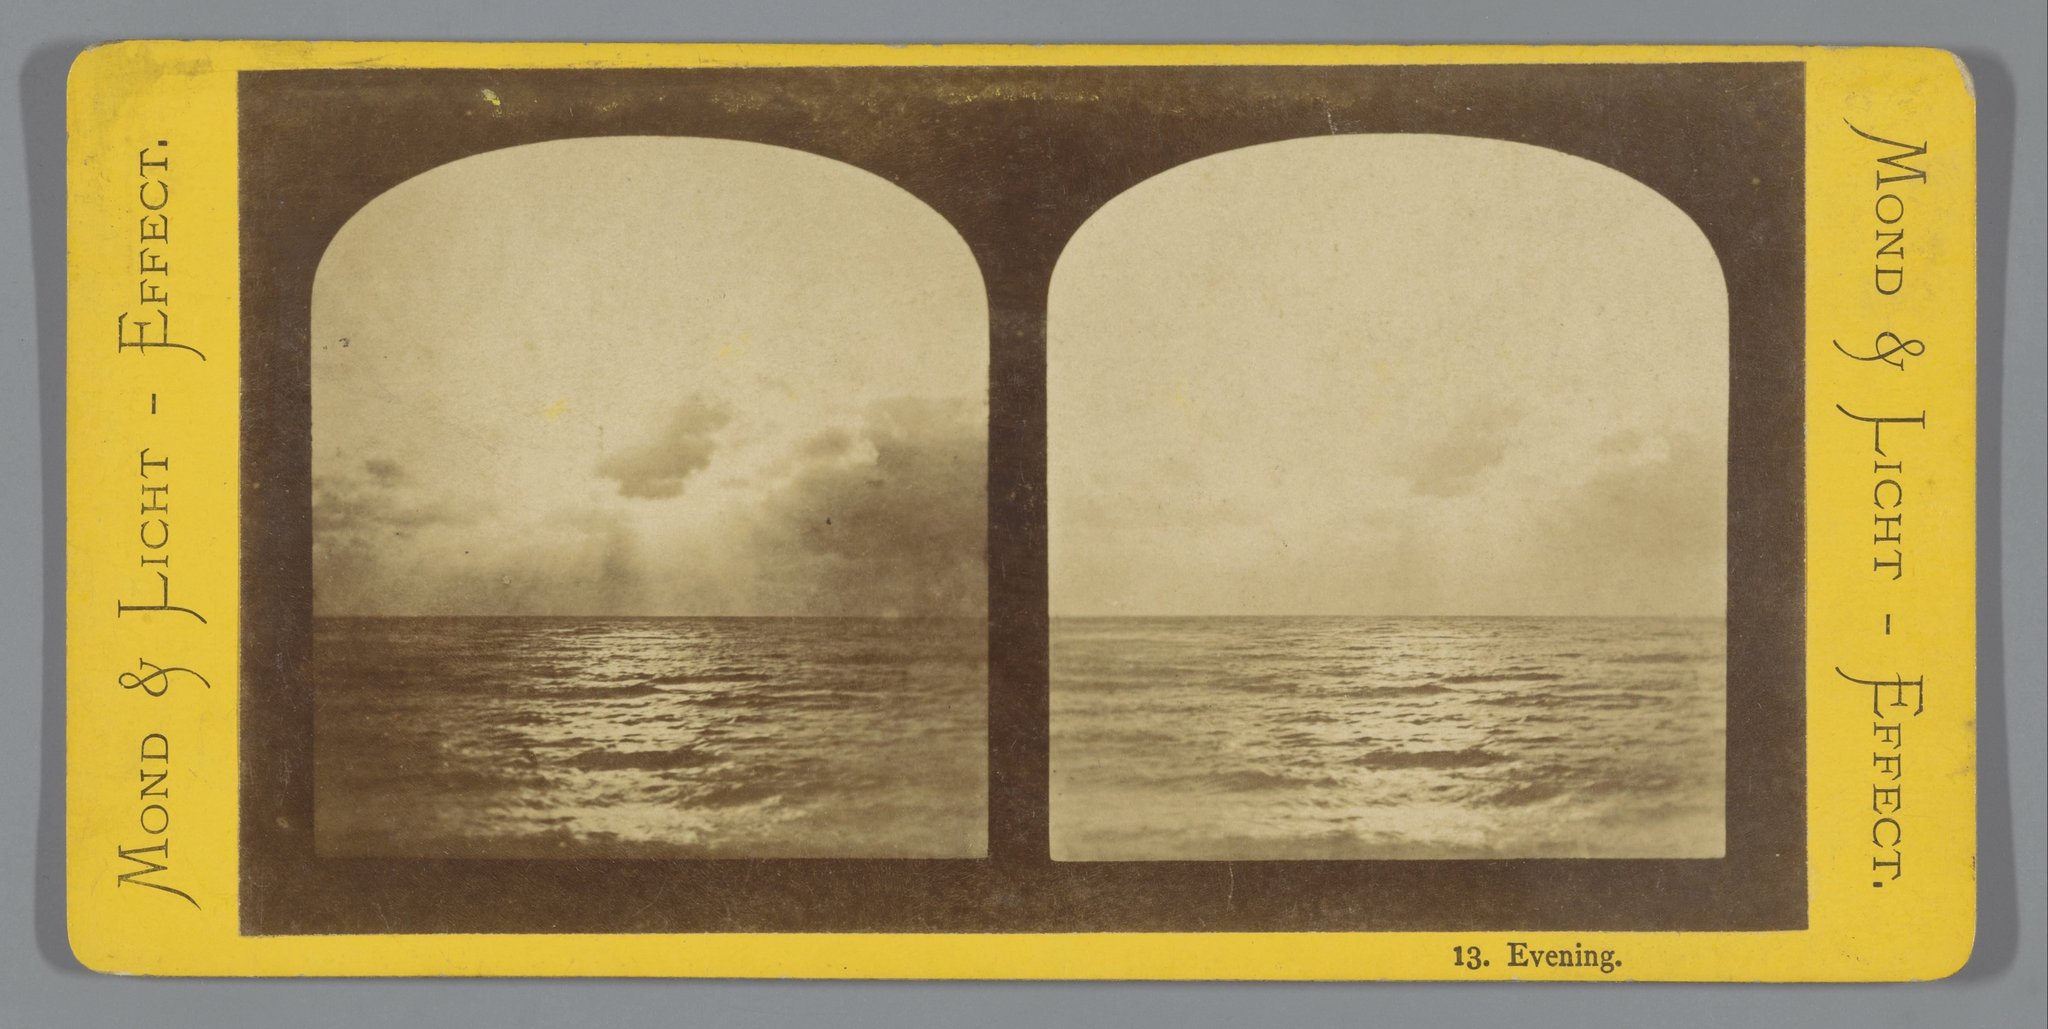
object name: stereograph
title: Mond & Licht-Effect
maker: Anonymous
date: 1868-1890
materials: cardboard, paper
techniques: albumen print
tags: ocean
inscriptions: number: ‘13’, number: ‘60’